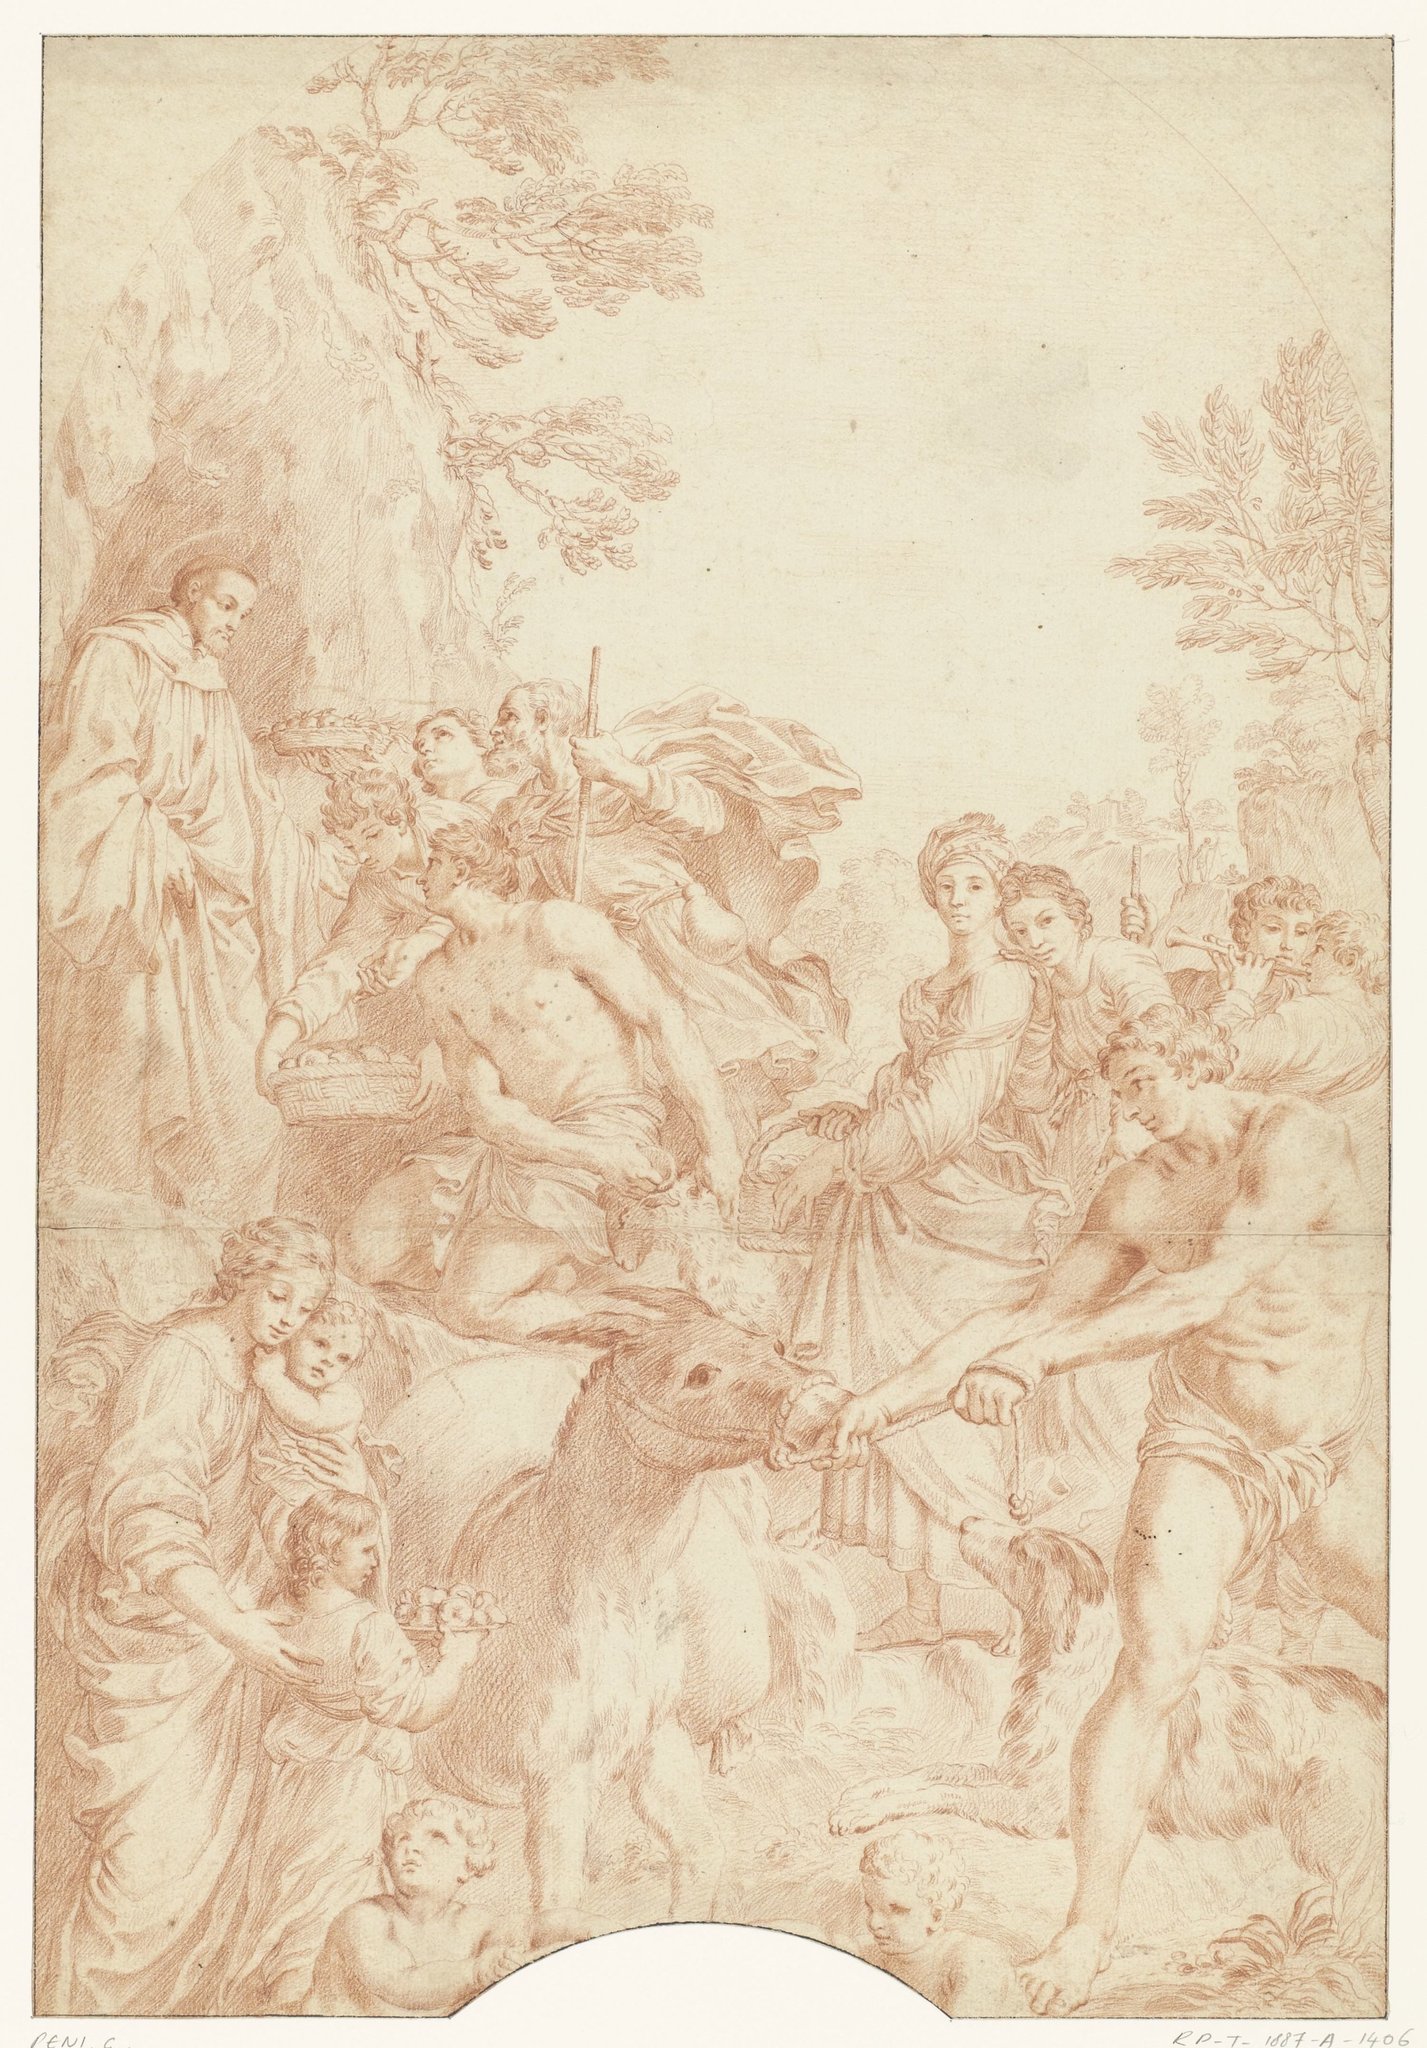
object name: drawing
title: H. Benedictus als kluizenaar ontvangt geschenken van landlieden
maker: Anonymous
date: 1585-1692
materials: chalk, paper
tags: st. benedict retreats into a rocky desert and lives in a cave ('sacro speco')